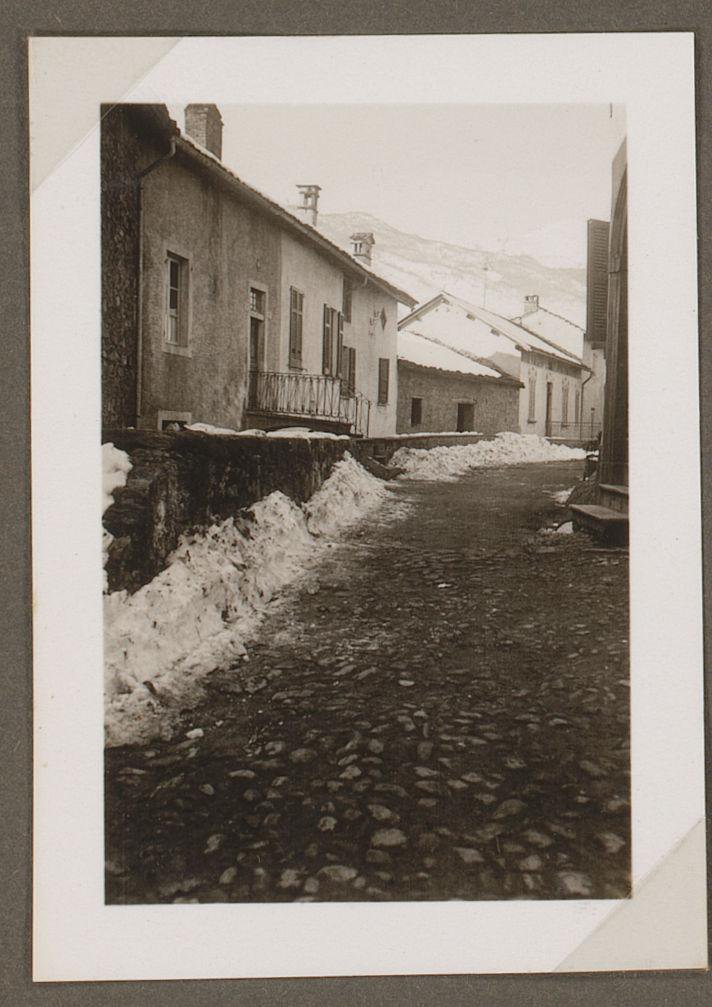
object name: album leaf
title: Ponte Capriasca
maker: Anonymous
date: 1933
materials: photographic support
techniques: gelatin silver print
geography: ponte capriasca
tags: village street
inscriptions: number: ‘28’